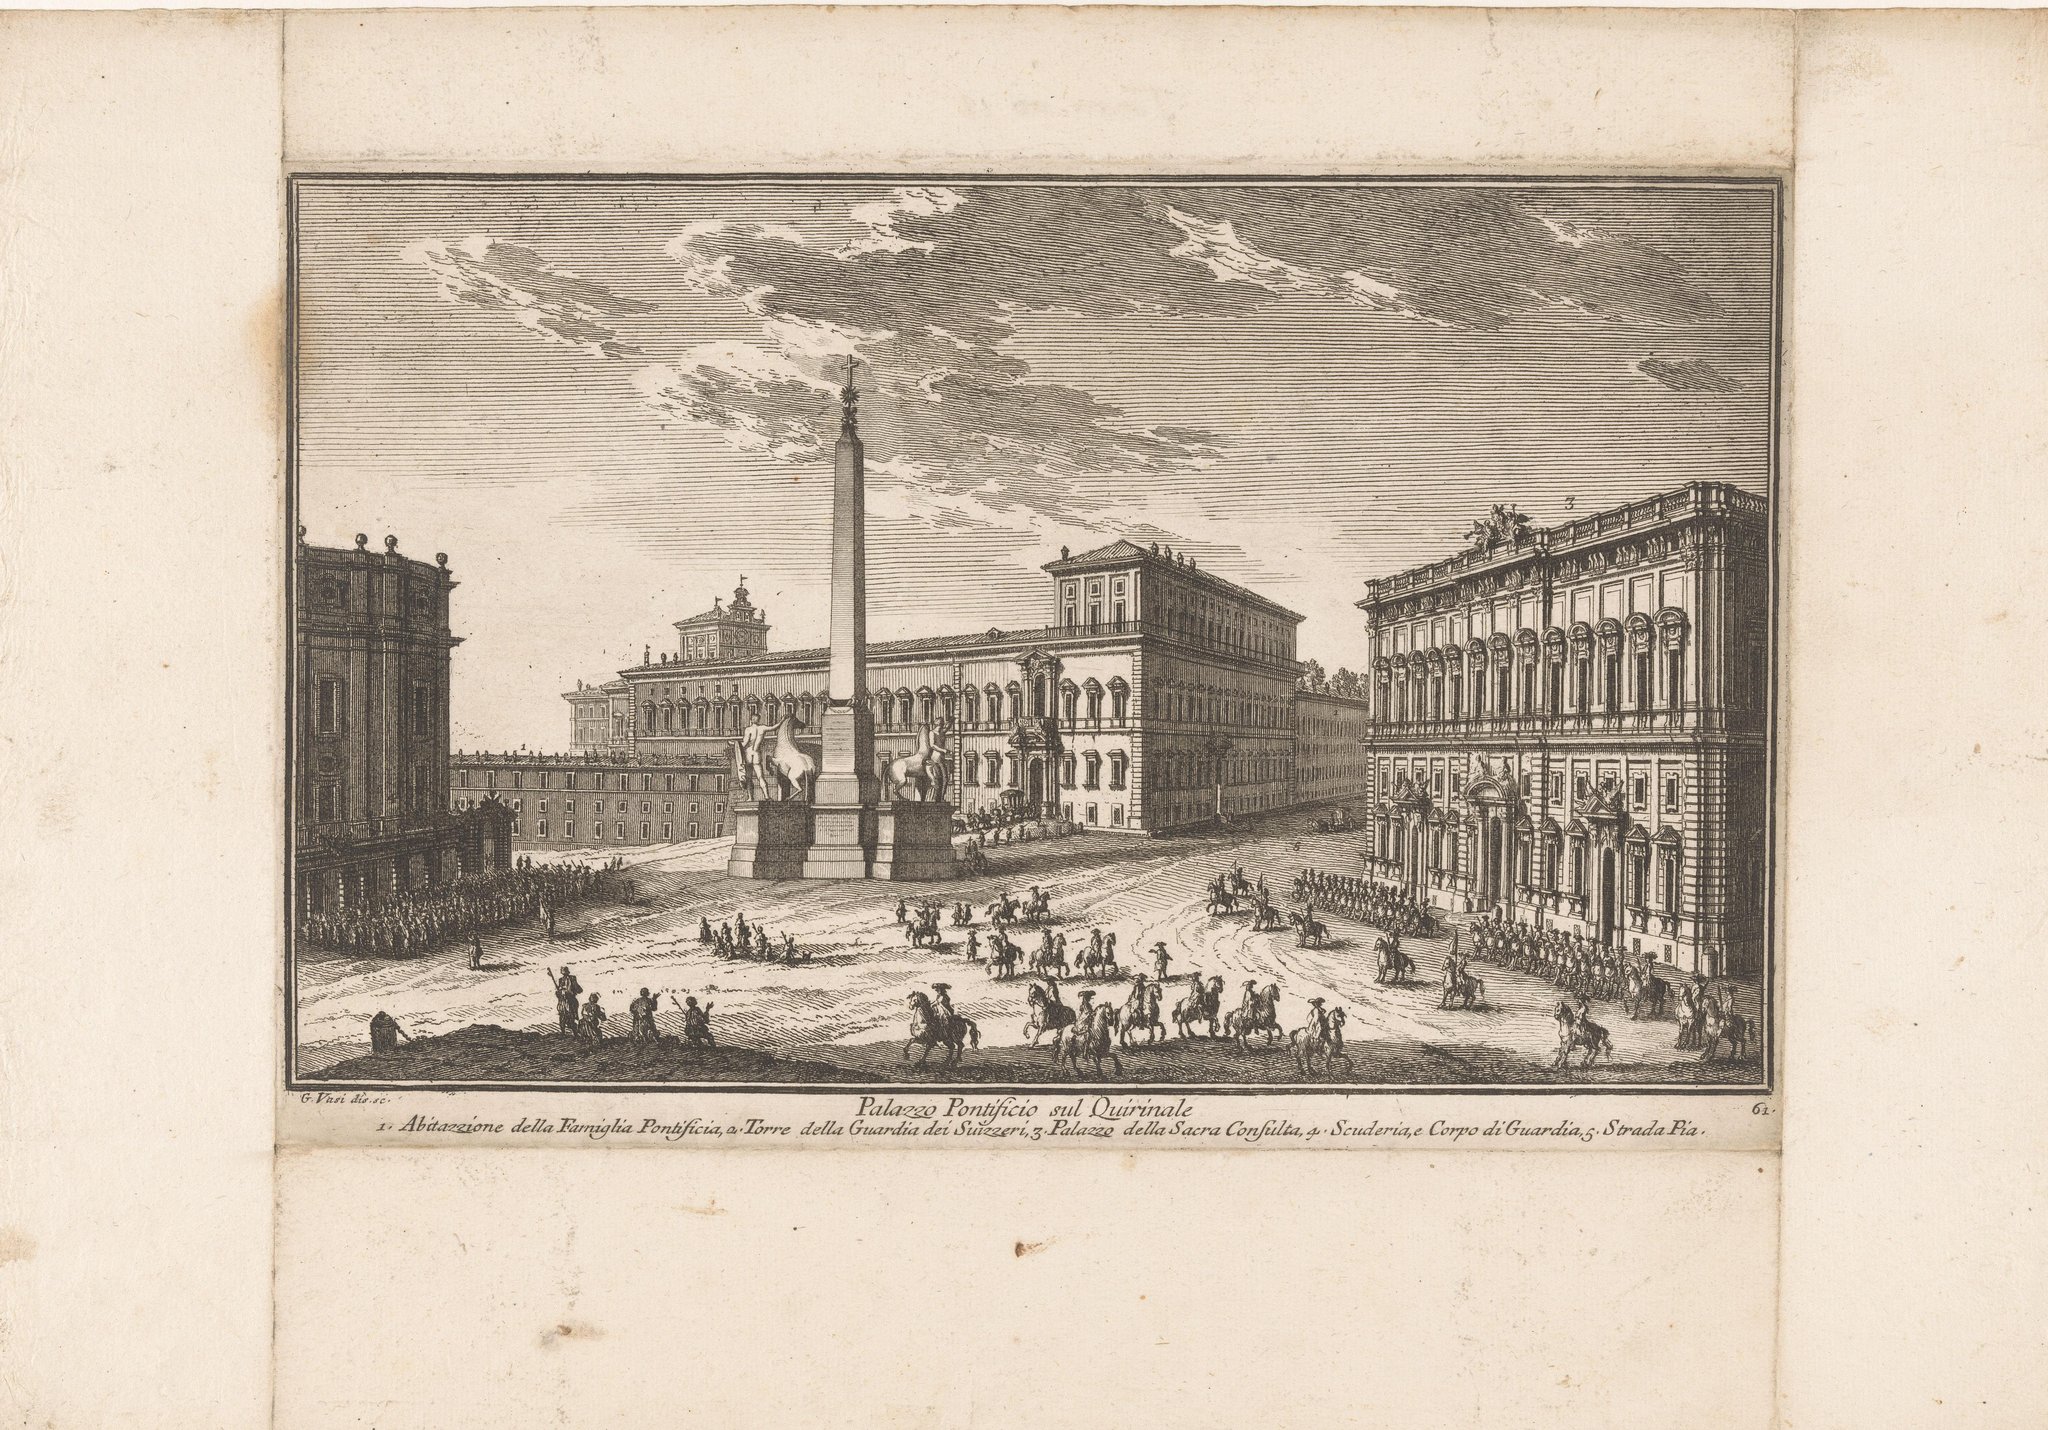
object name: print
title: Palazzo Pontificio sul Quirinale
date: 1747-1761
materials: paper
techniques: etching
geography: italy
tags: obelisk, needle, city-view in general; 'veduta', ornamental fountain, rome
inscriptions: collector's mark: Lugt 2228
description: Deze prent maakt deel uit van Giuseppe Vasi's serie gezichten op Rome, getiteld 'Delle Magnificenze di Roma Antica e Moderna'. De serie bestaat uit tien delen met elk twintig prenten en werd gepubliceerd tussen 1747 en 1761. De obelisk die op deze prent staat afgebeeld werd pas op Piazza del Quirinale geplaatst in 1786-87, na de dood van Giuseppe Vasi. Vermoedelijk werd de plaat bewerkt door zijn zoon Mariano.